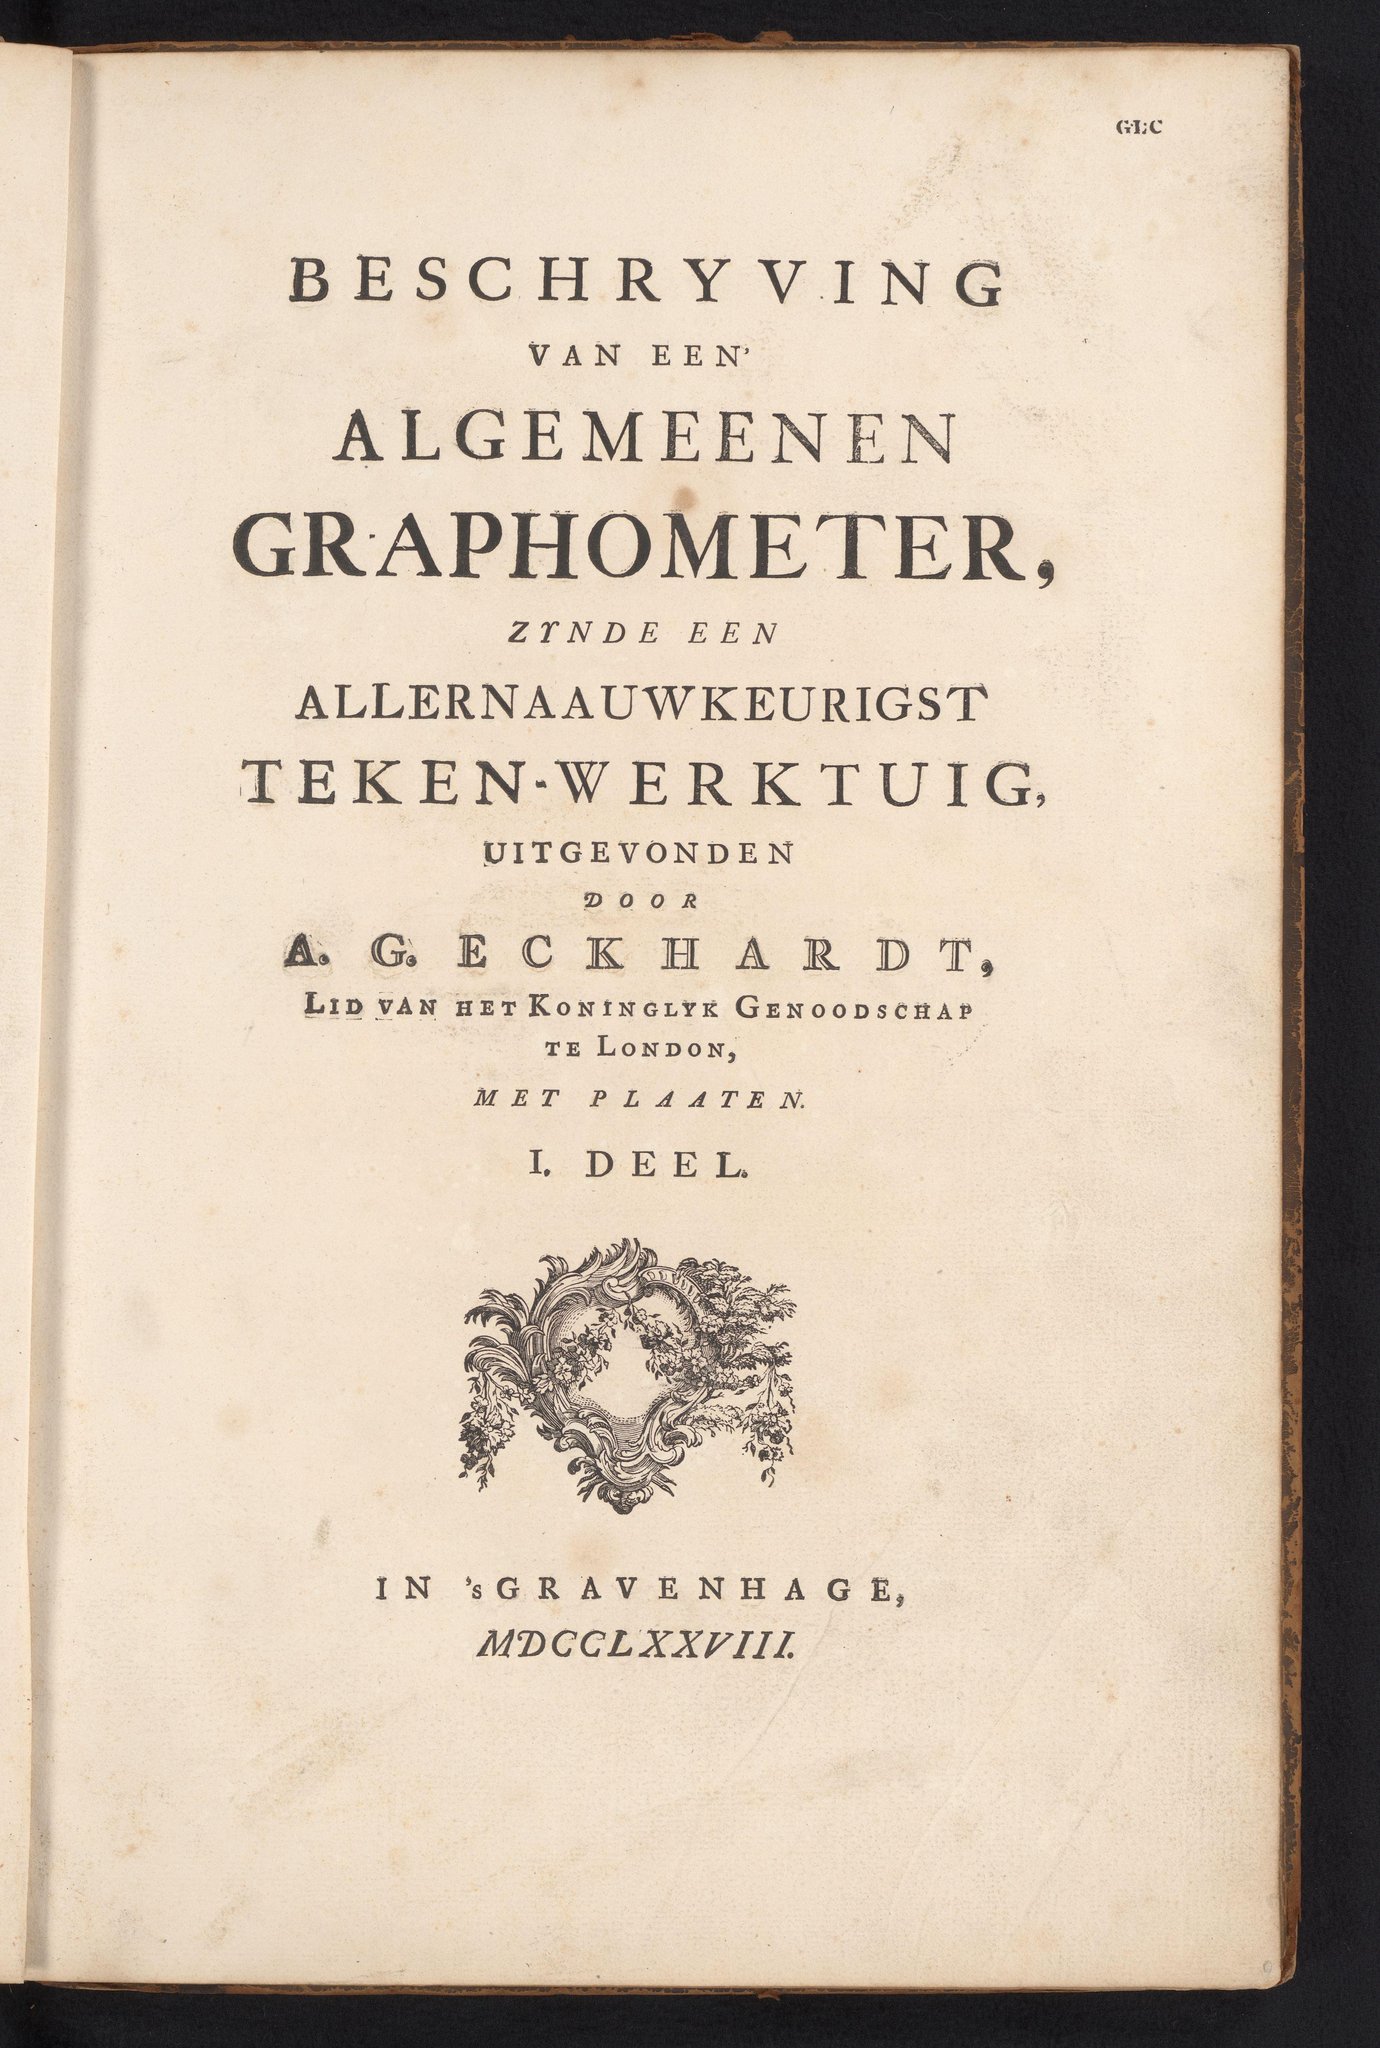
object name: titelblad, titelpagina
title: Titelpagina voor: A.G. Eckhardt, Beschryving van een algemeenen graphometer, 1778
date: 1777-1778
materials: paper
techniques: letterpress printing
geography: the hague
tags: title-page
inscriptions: collector's mark: ‘G.L.C’